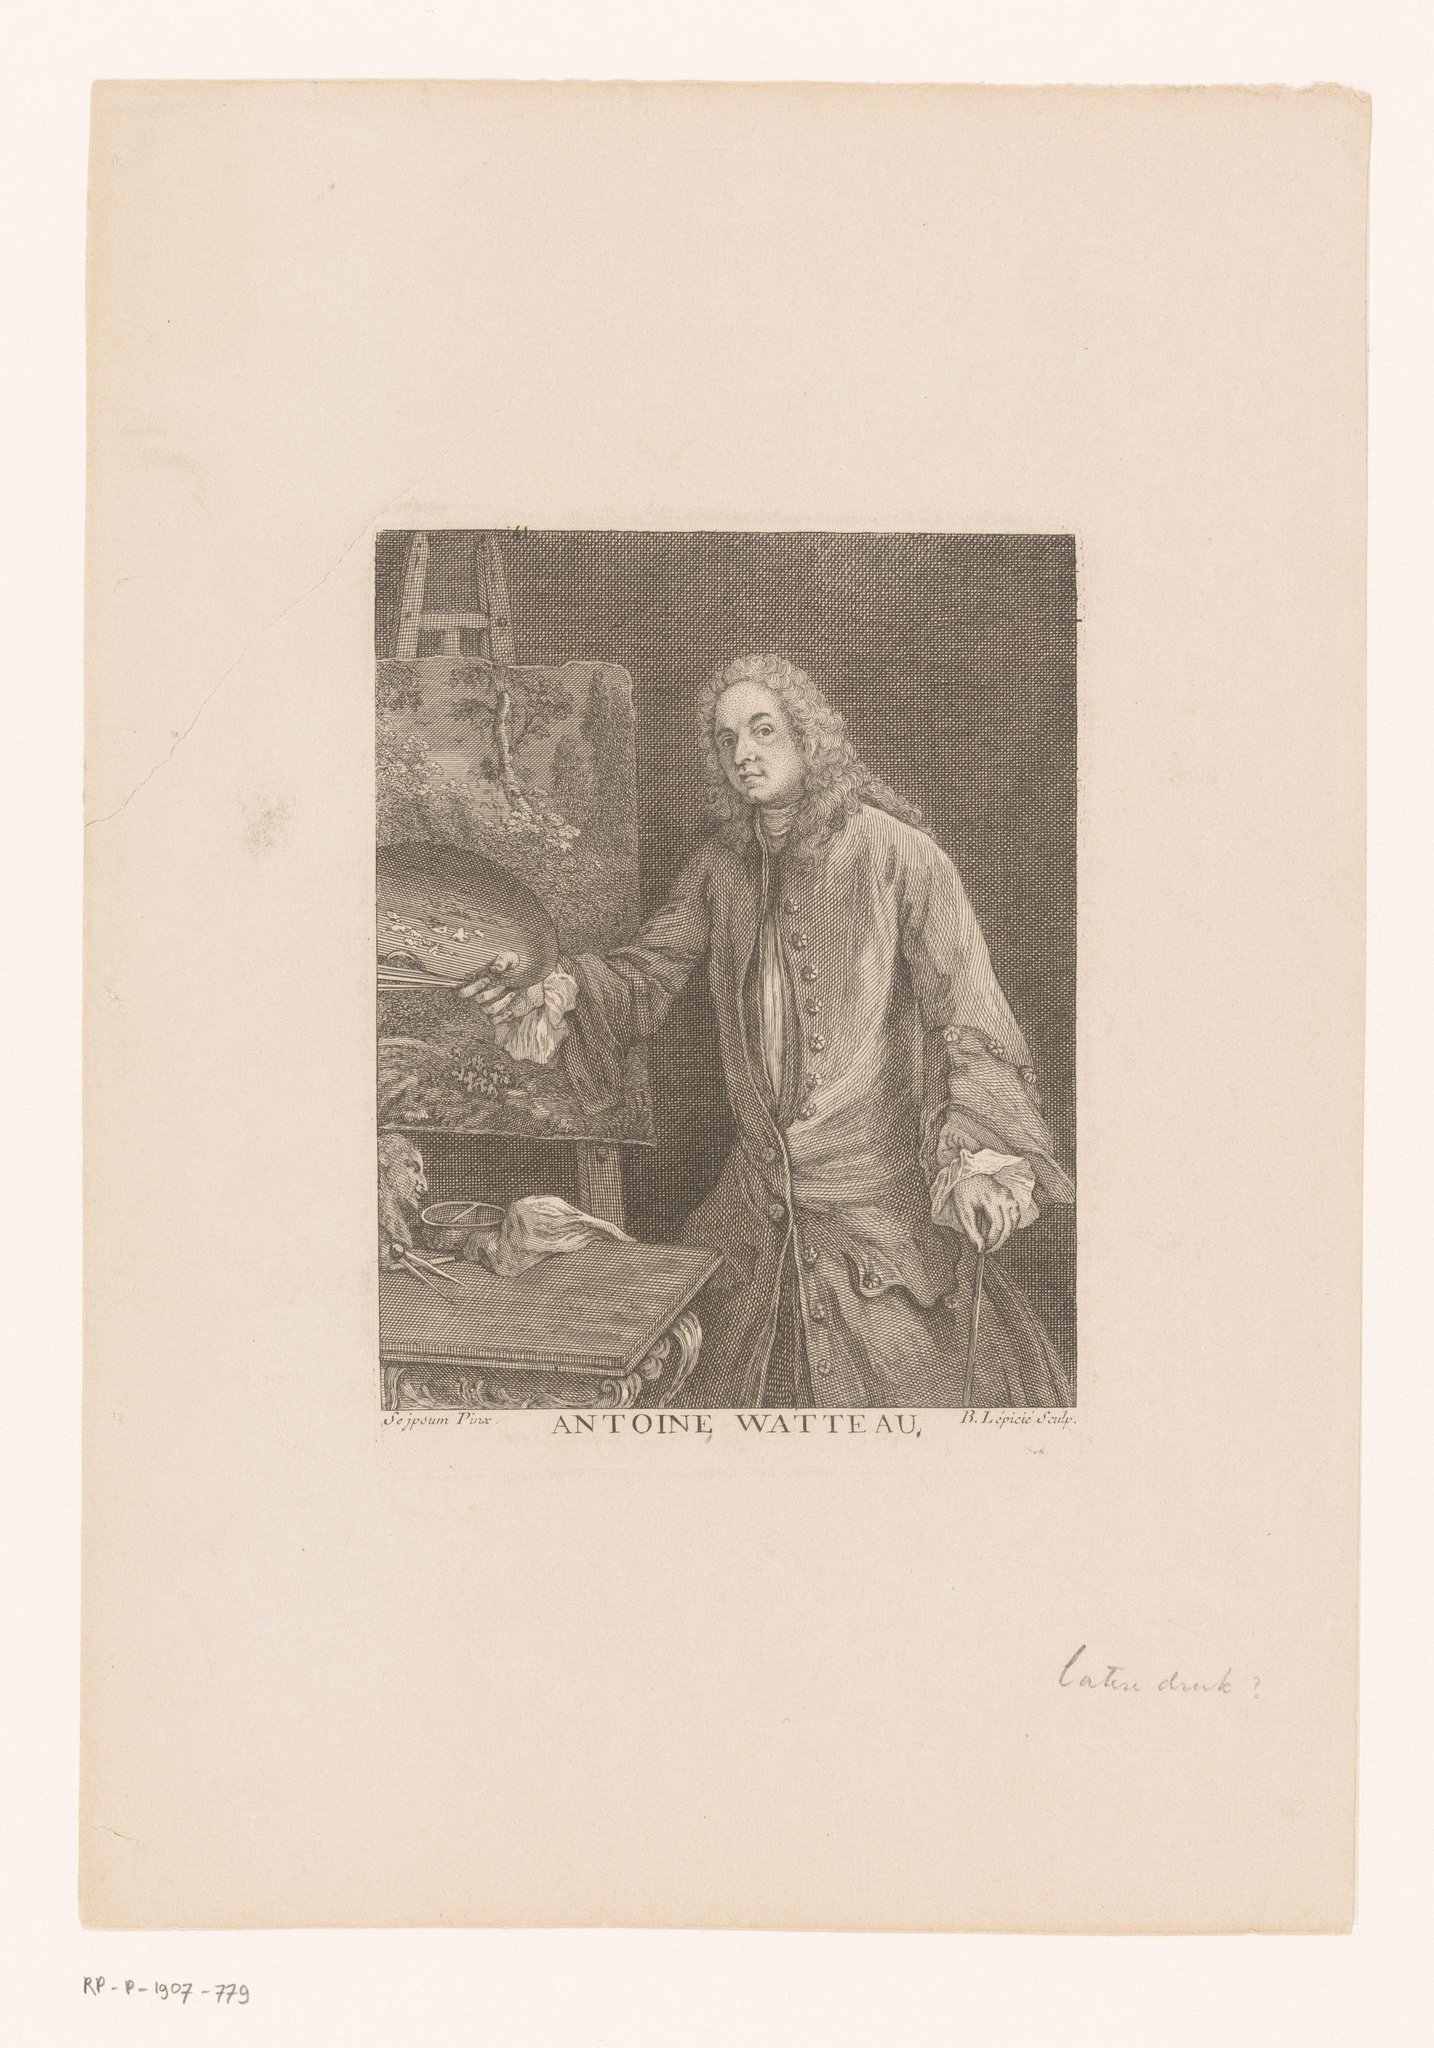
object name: print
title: Portret van Jean Antoine Watteau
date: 1708-1755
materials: paper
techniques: etching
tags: print maker, draughtsman, jean antoine watteau, historical persons, portrait, self-portrait of painter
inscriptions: collector's mark: Lugt 2228